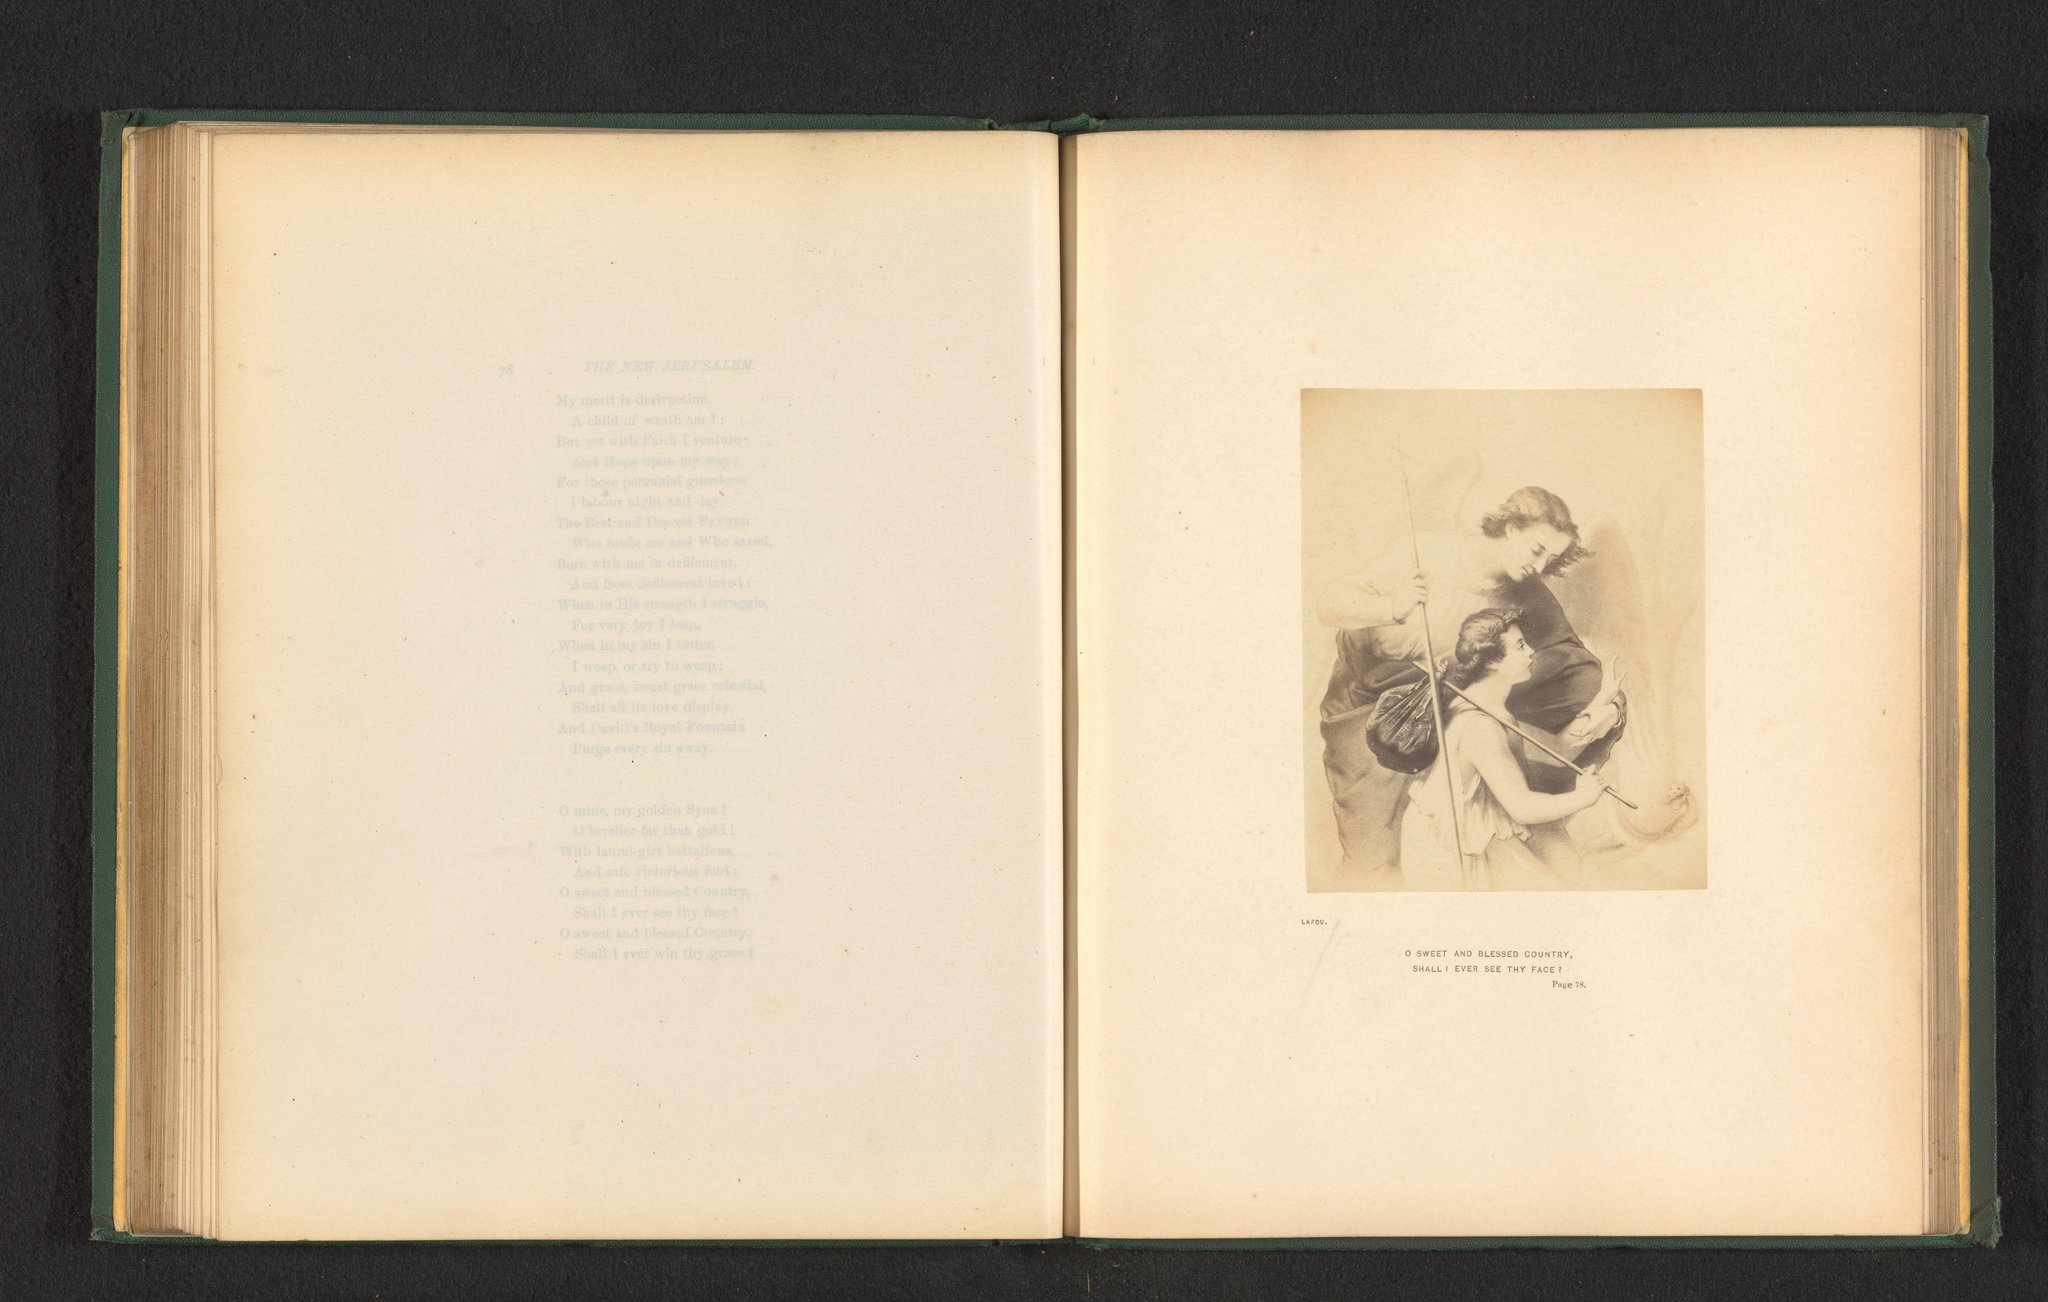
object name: reproduction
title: O sweet and blessed country, shall I ever see thy face ?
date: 1860-1865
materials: photographic support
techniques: albumen print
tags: snakes, child, guardian angel